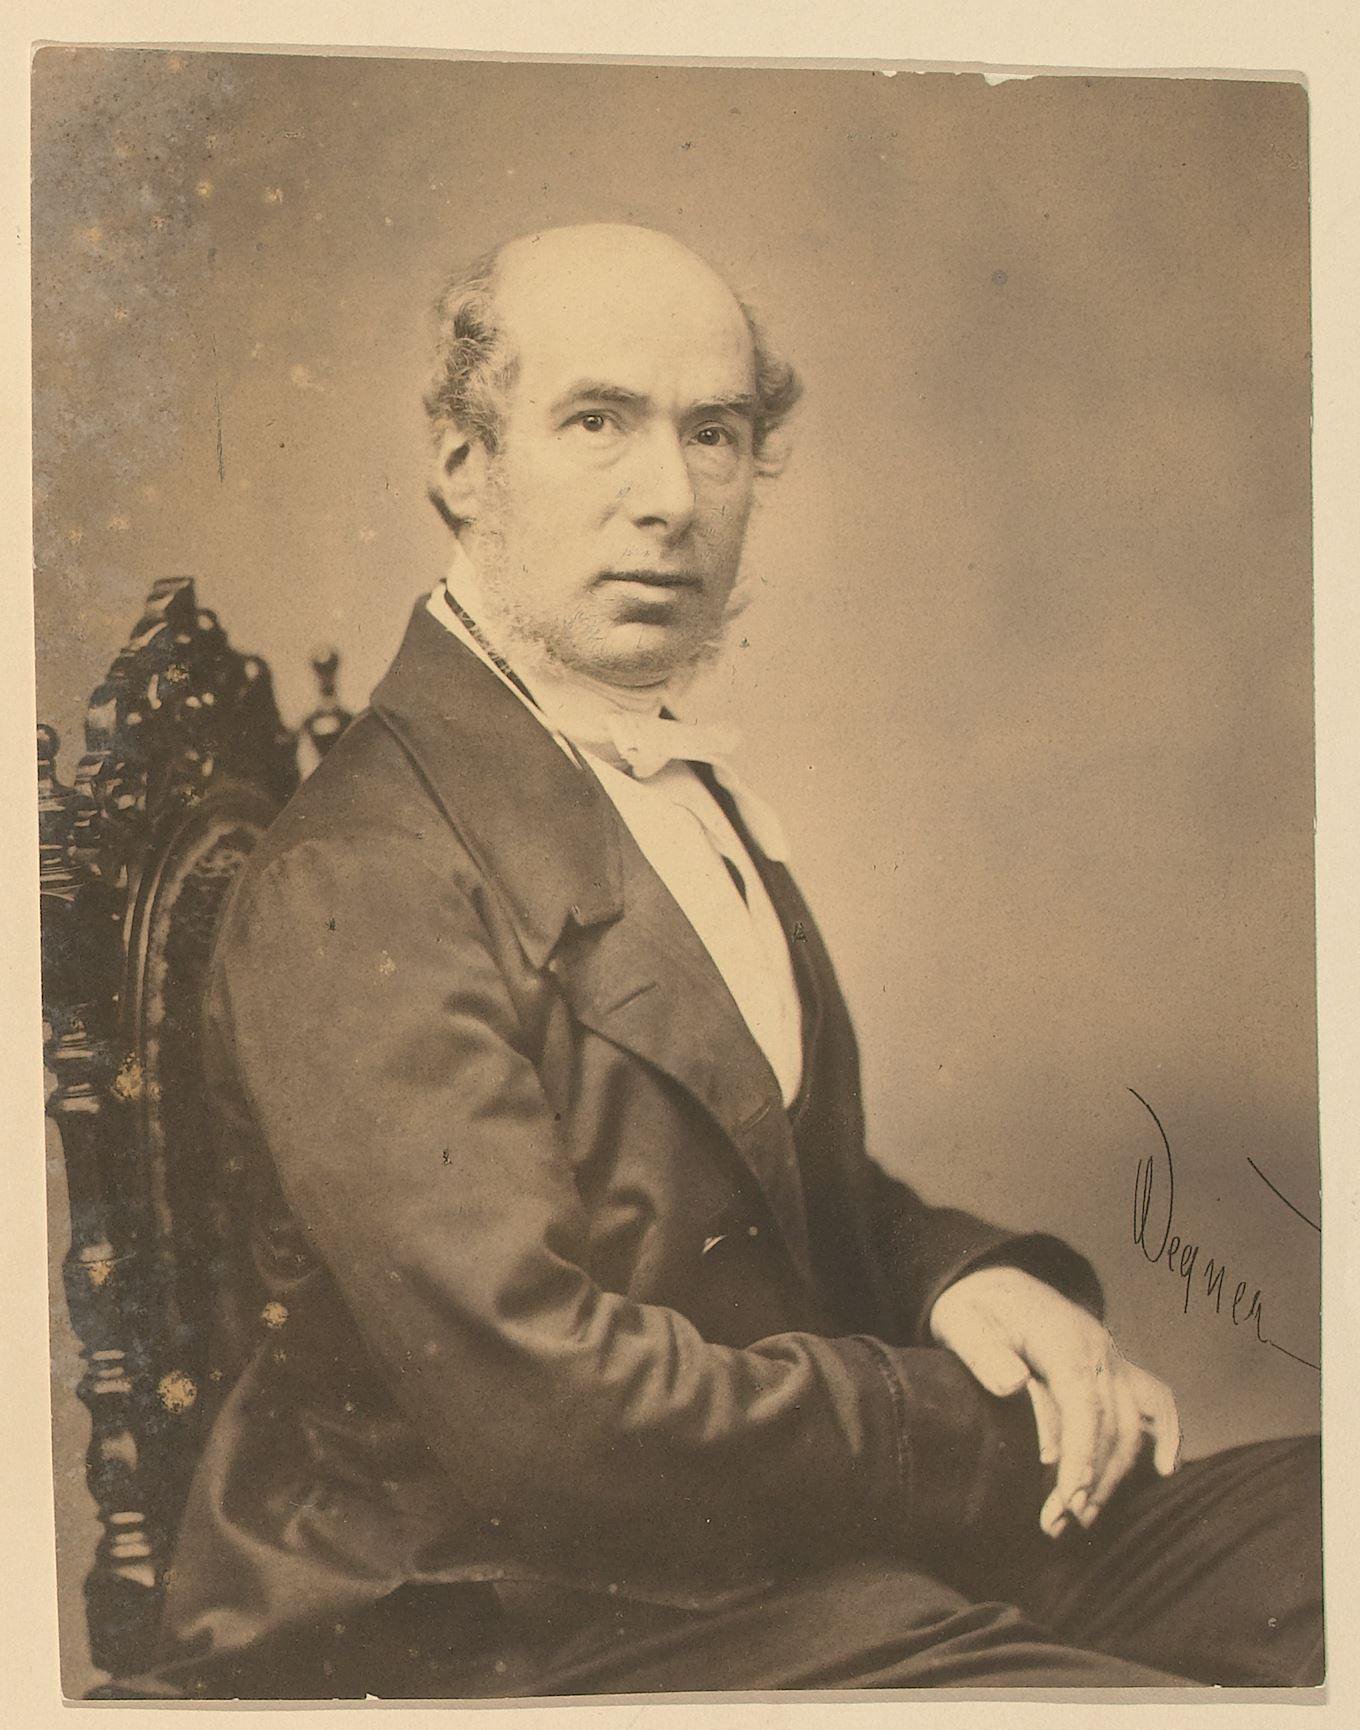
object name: photograph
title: Portret van Eduard Isaac Asser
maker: louis wegner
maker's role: print maker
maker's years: 1816-1864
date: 1856-1858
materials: cardboard, paper, photographic support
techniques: albumen print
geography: amsterdam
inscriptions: signature: ‘Wegner’